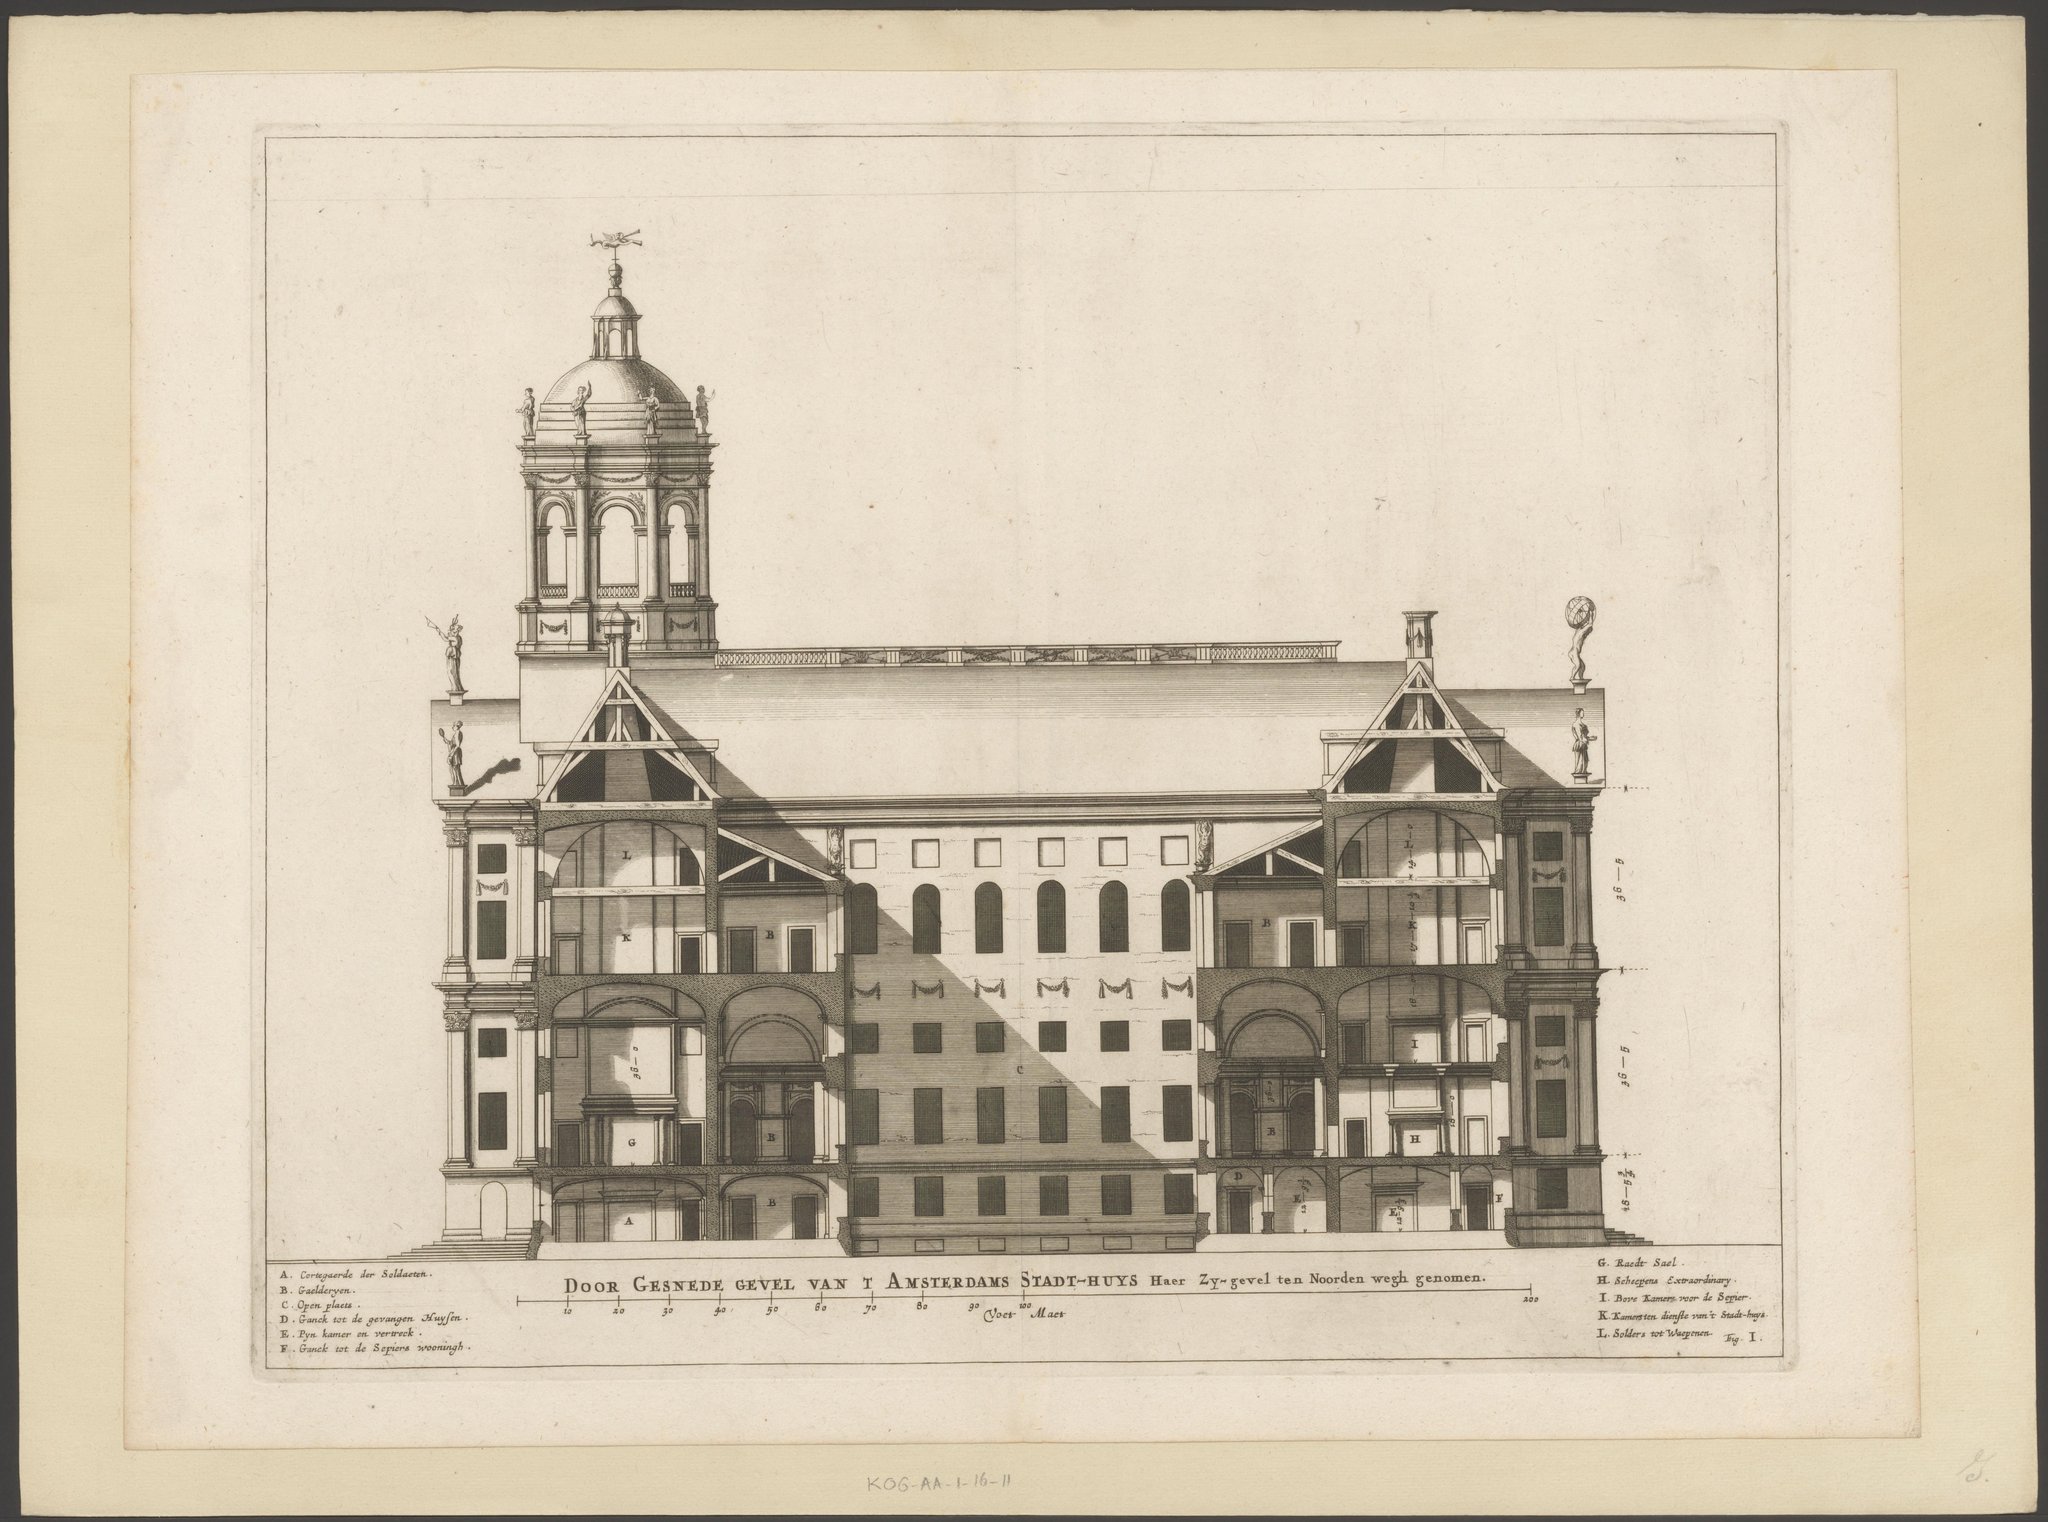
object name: print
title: Doorsnede van het Stadhuis op de Dam, door de breedte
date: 1661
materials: paper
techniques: engraving, etching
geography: amsterdam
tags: interior ~ architectural design or model, townhall, façade (of house or building)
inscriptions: collector's mark: ‘16,11’ Lugt 1641b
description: Onderwerpsrubriek binnen de Atlas Amsterdam: Stadhuis op de Dam. Rechtsonder: Fig. I.